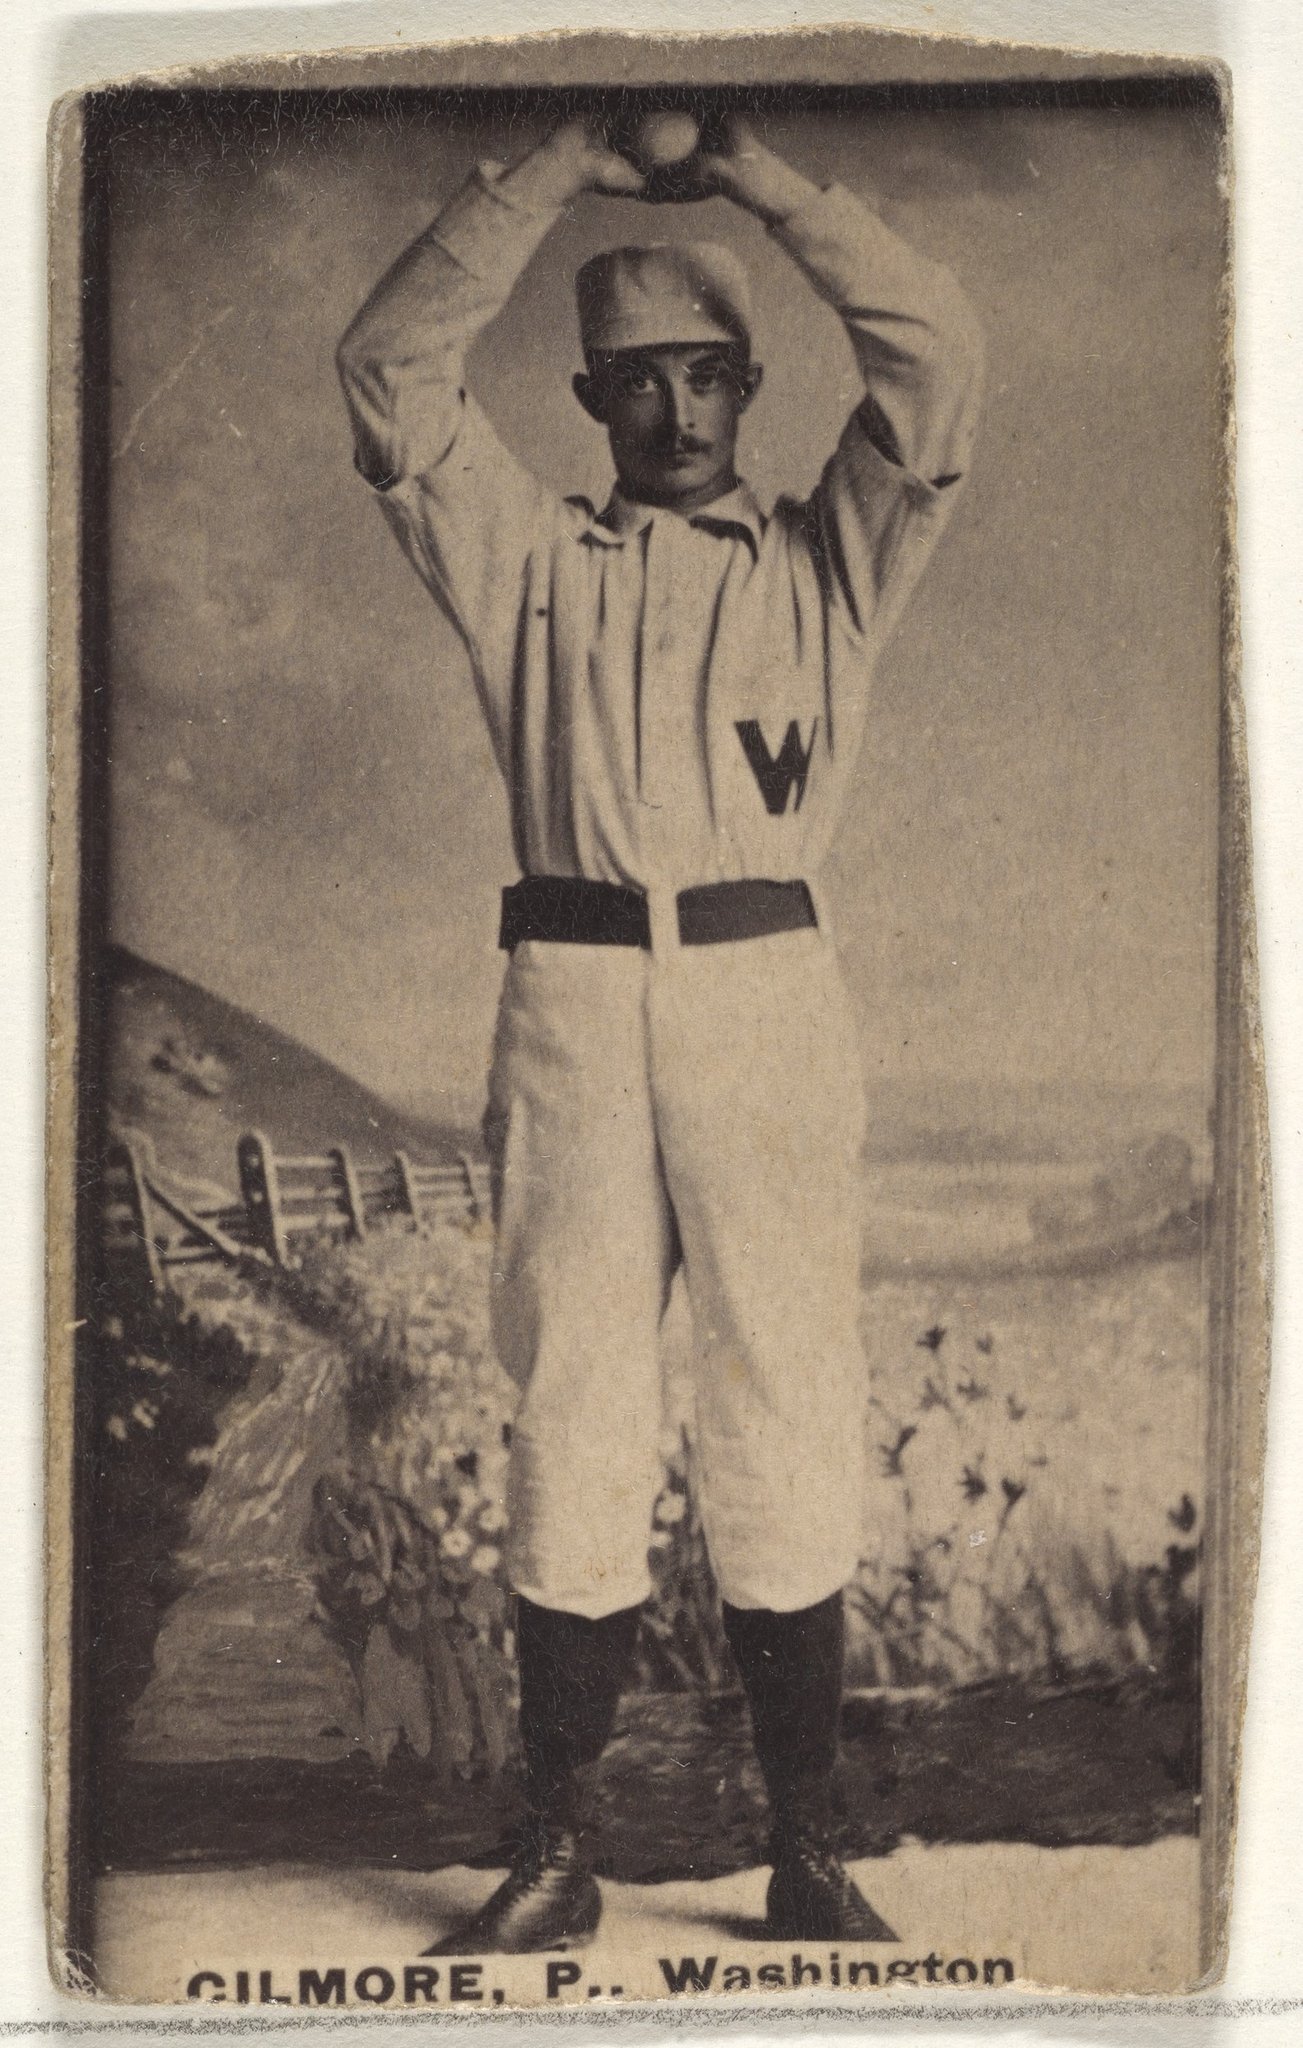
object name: baseball card, photograph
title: Frank T. Gilmore, Pitcher, Washington Nationals, from the Old Judge series (N172) for Old Judge Cigarettes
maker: goodwin & company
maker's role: publisher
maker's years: 1850-1950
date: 1887-1890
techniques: albumen silver print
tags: men,portraits,baseball,athletes